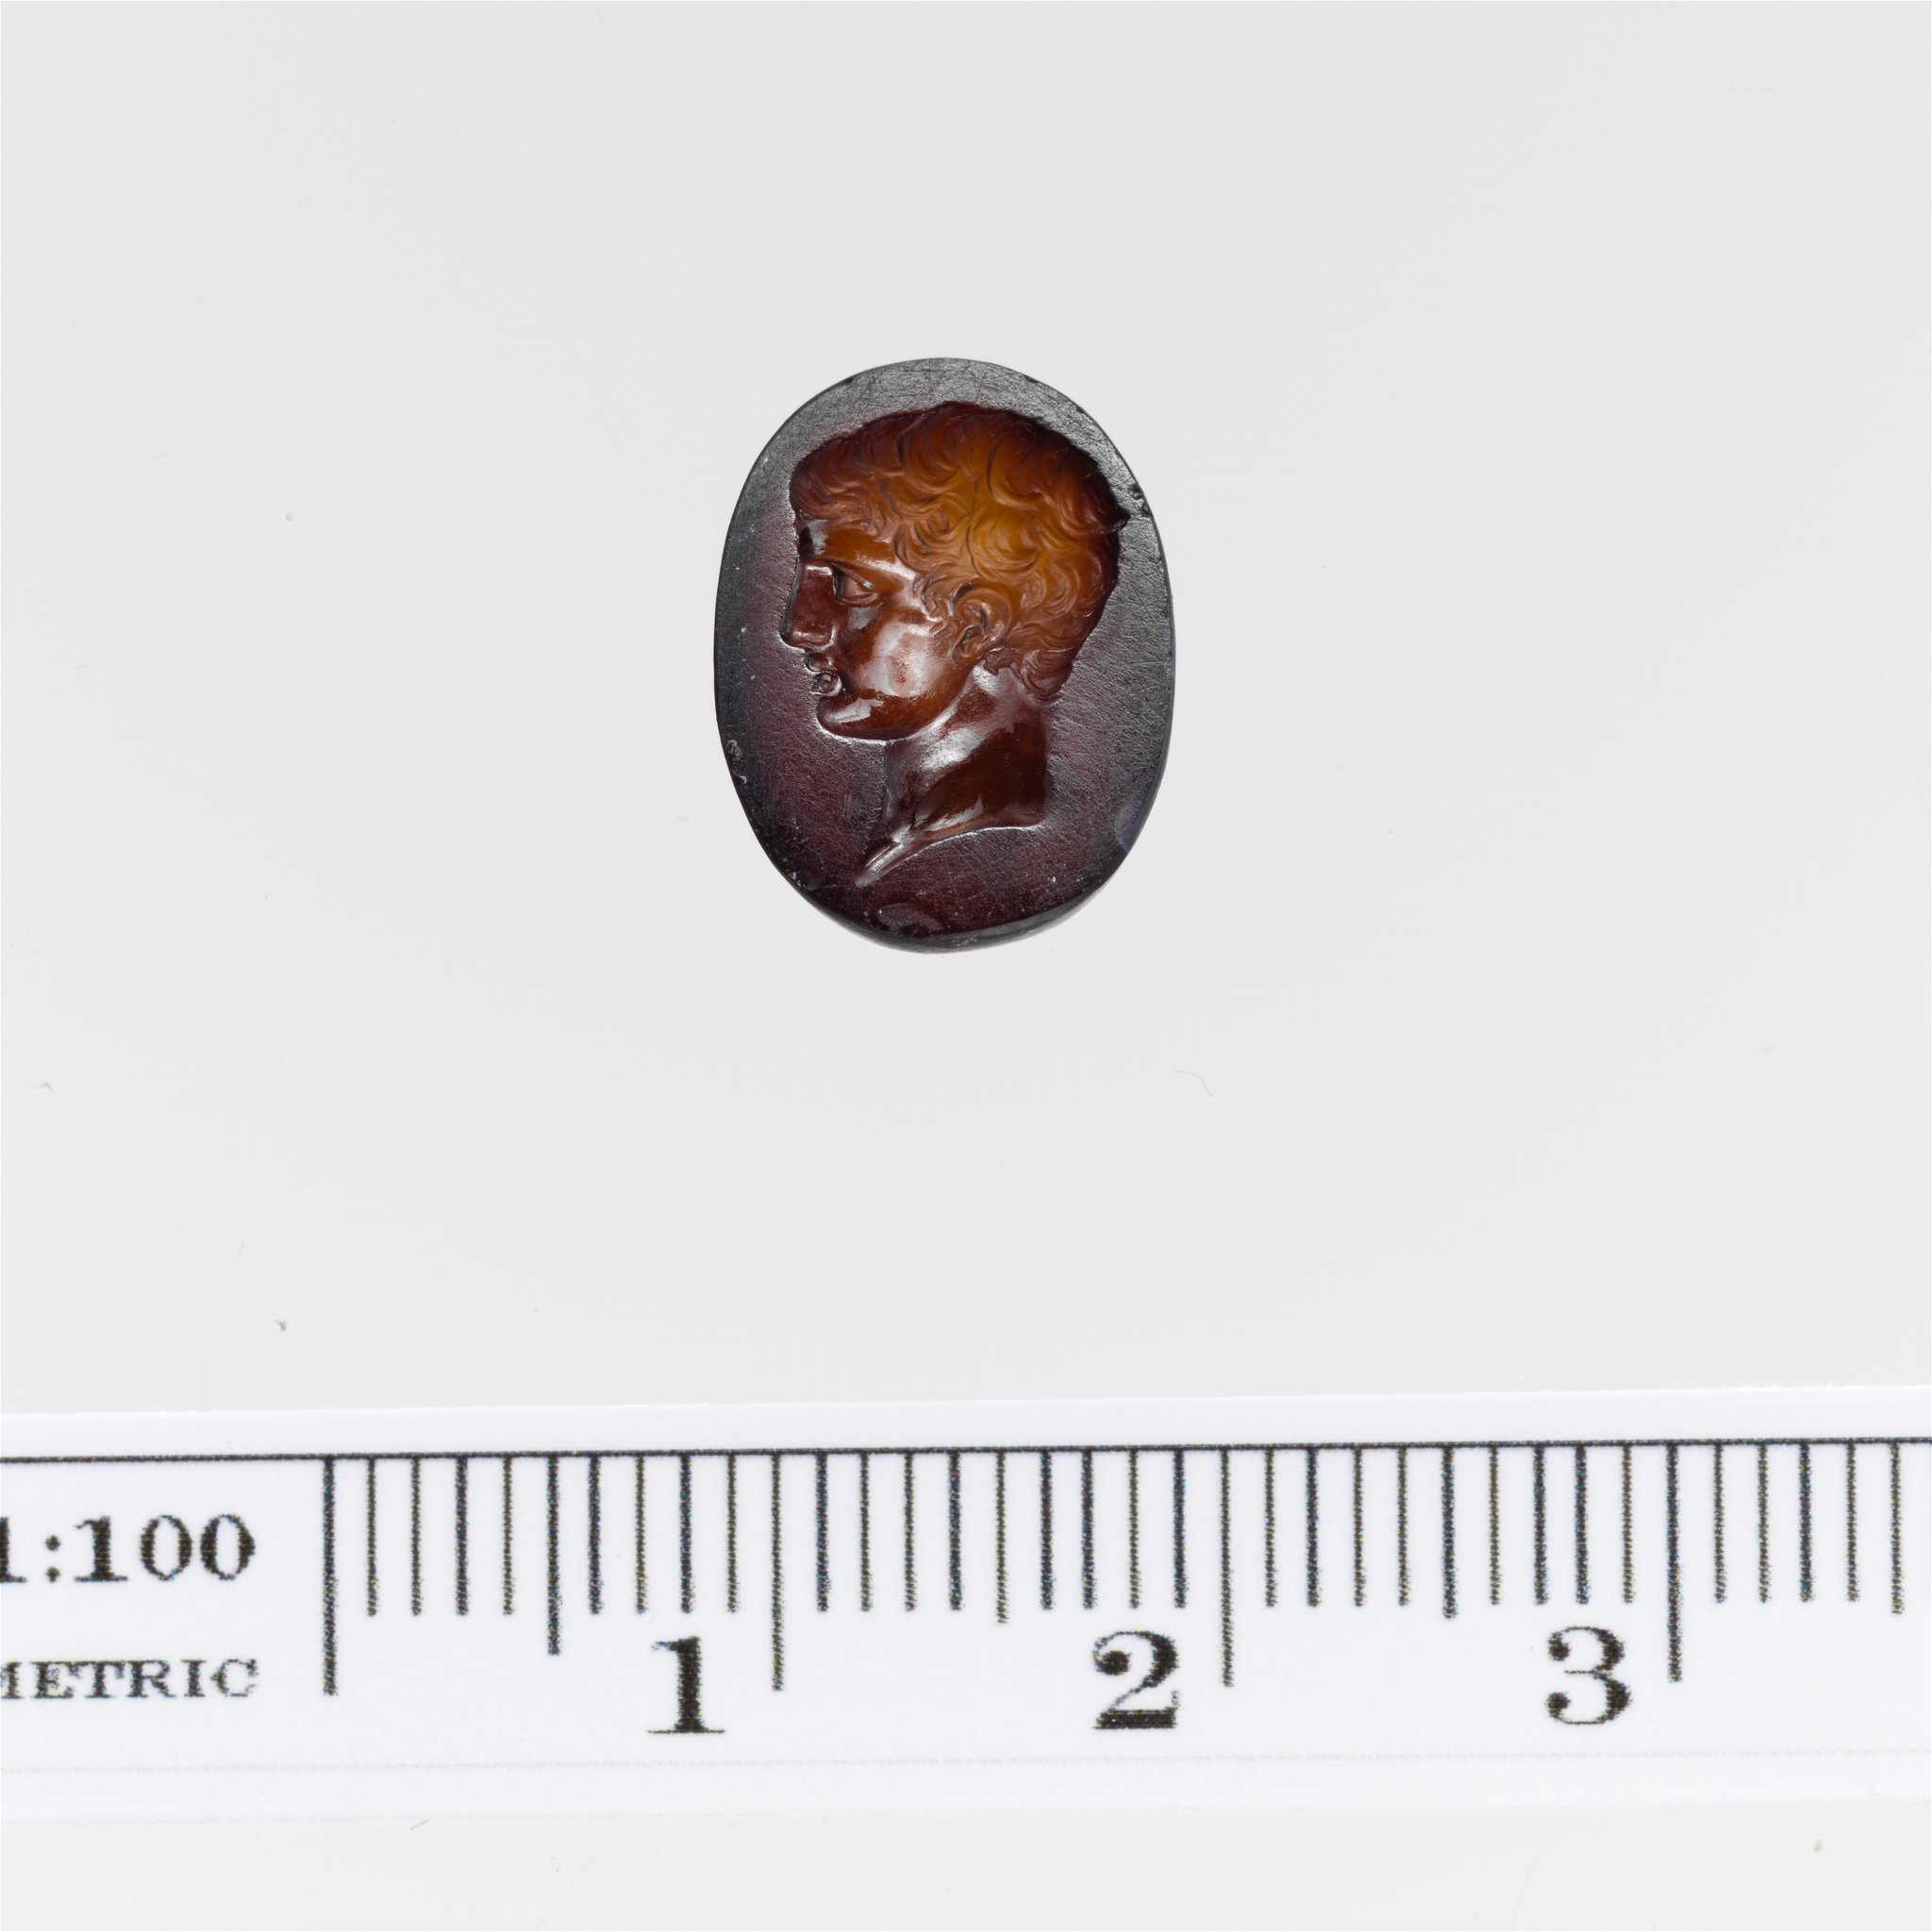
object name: intaglio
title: Carnelian ring stone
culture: roman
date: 1-100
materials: gemstone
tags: men,profiles